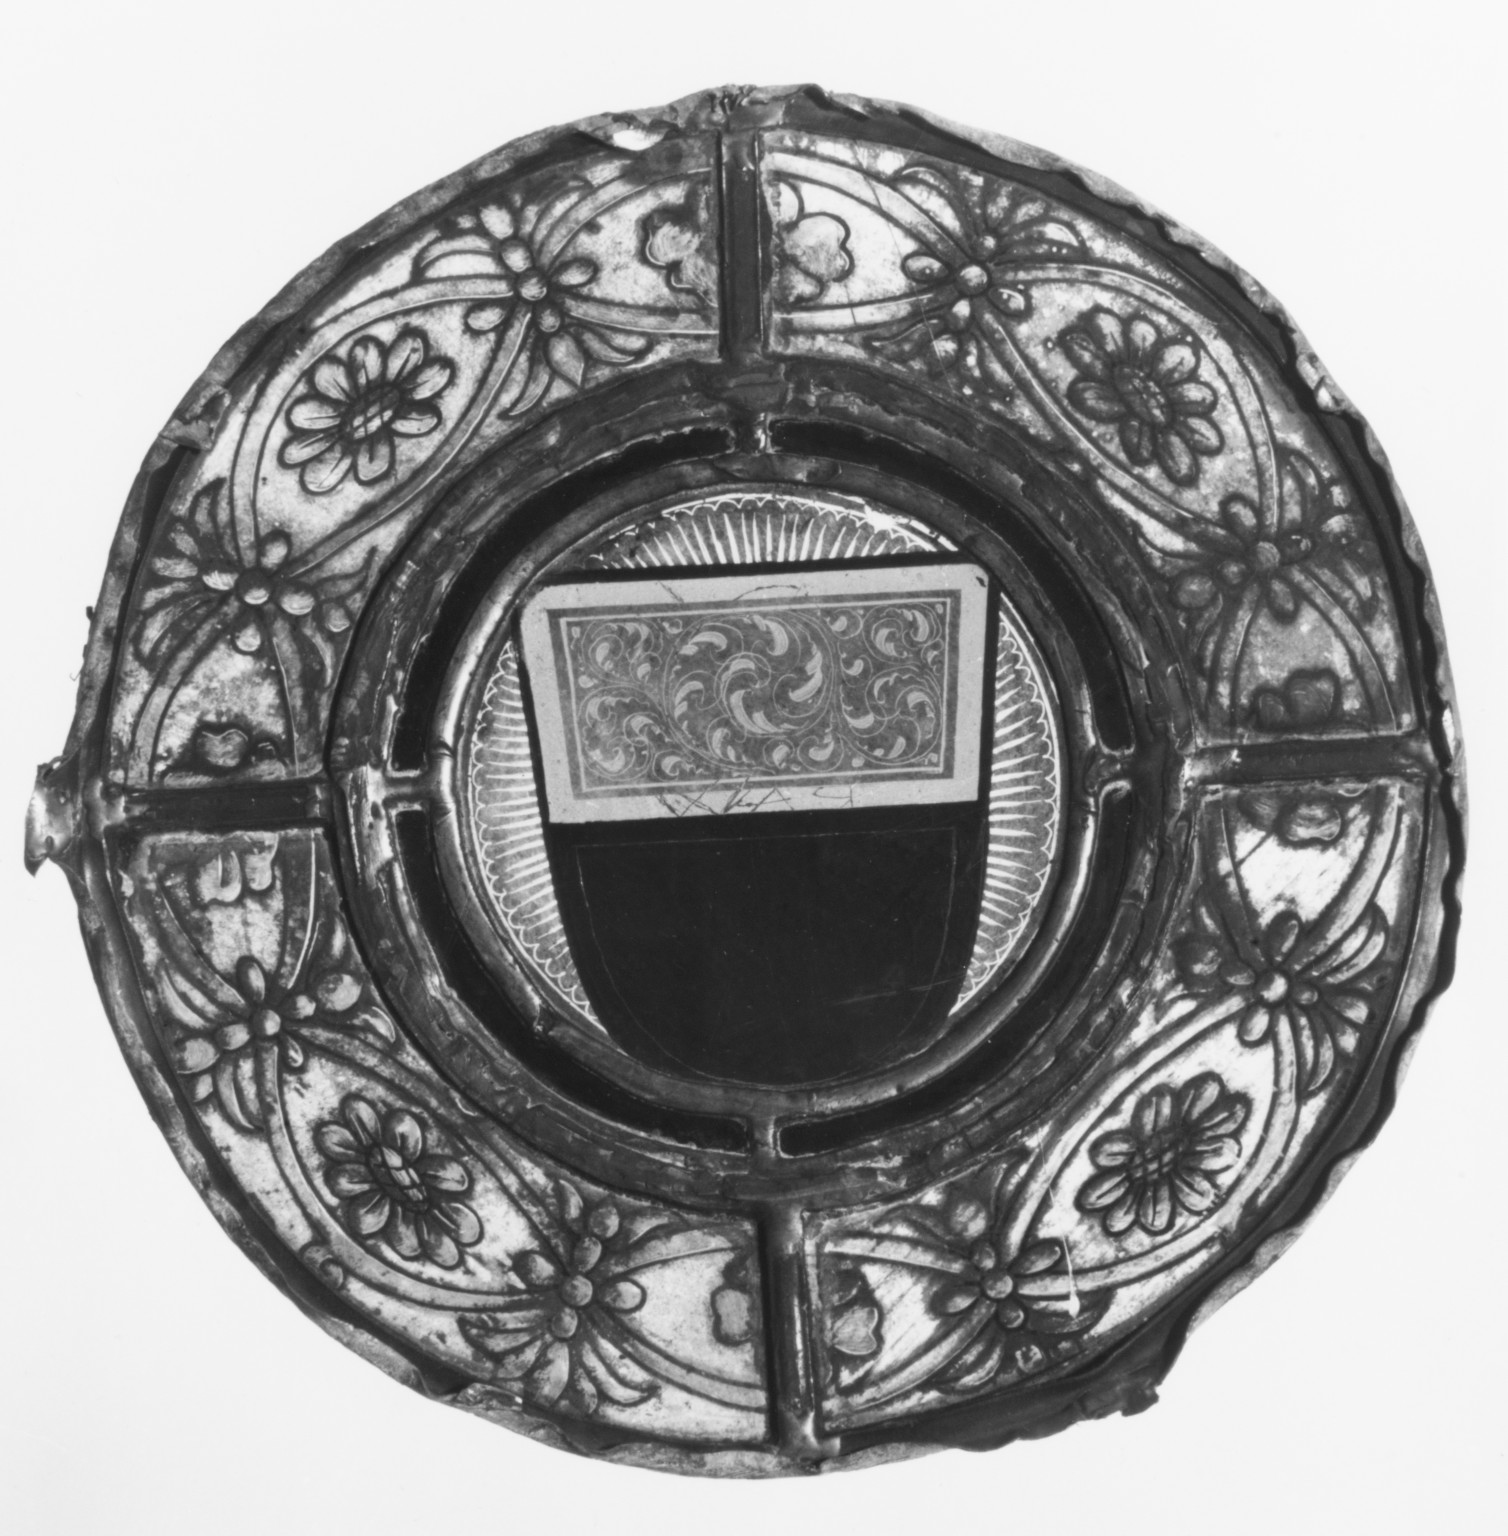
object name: armorial panel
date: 1567-1600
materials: glass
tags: flowers,coat of arms